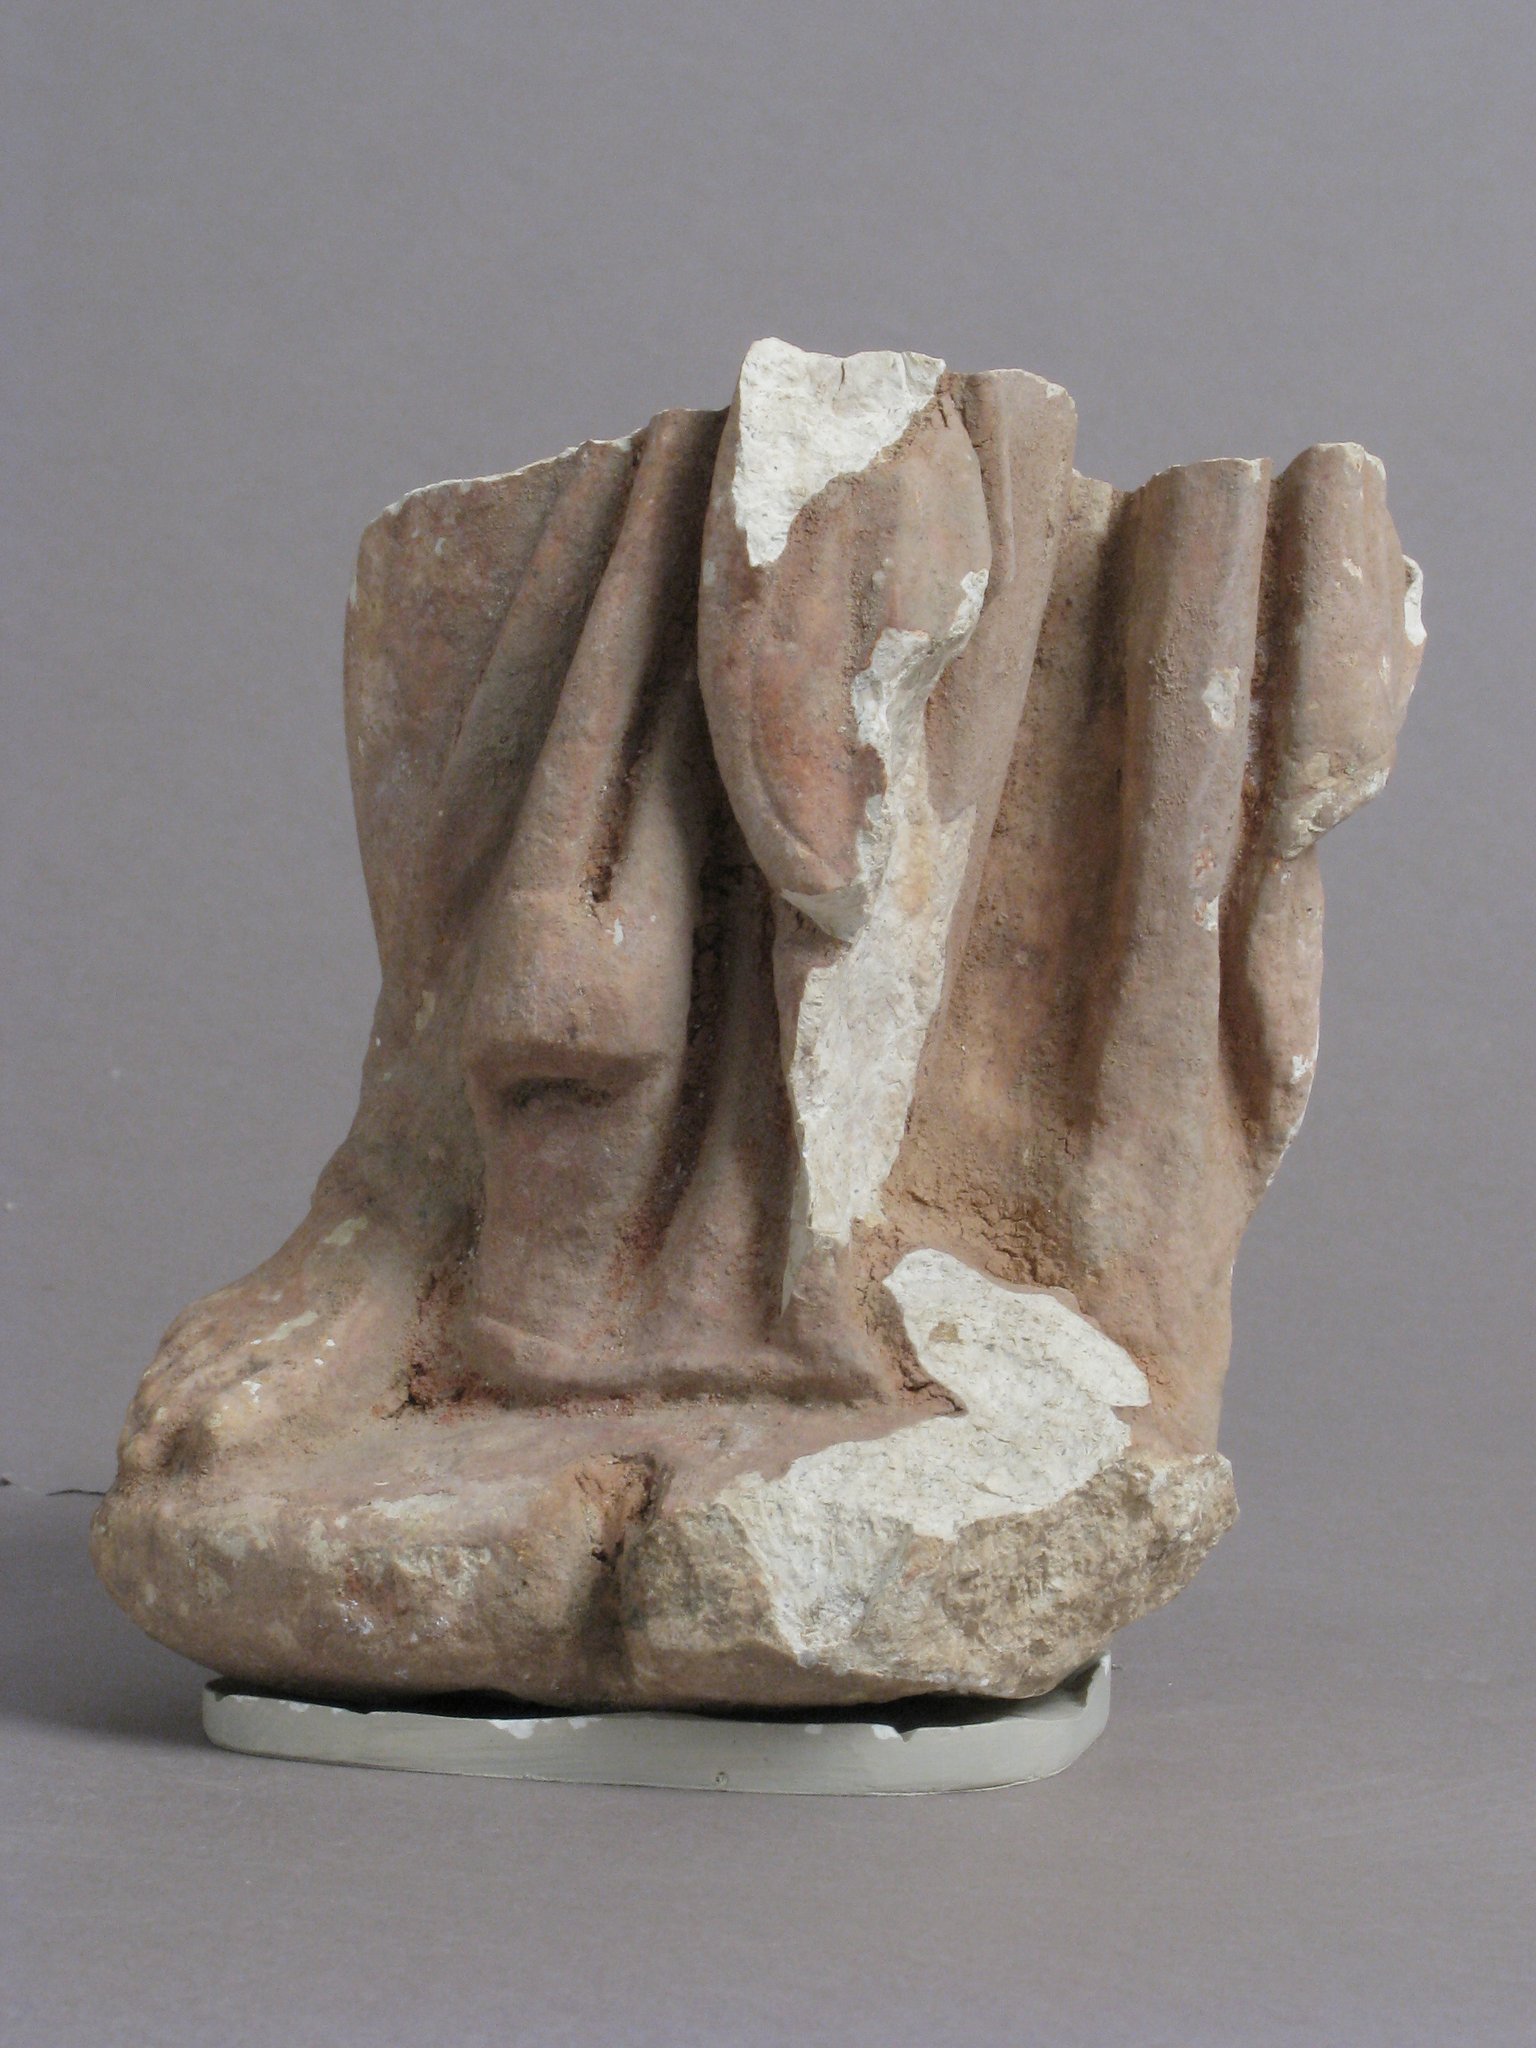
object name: statuette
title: Lower Legs Fragment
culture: coptic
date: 301-700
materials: marble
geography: egypt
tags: legs